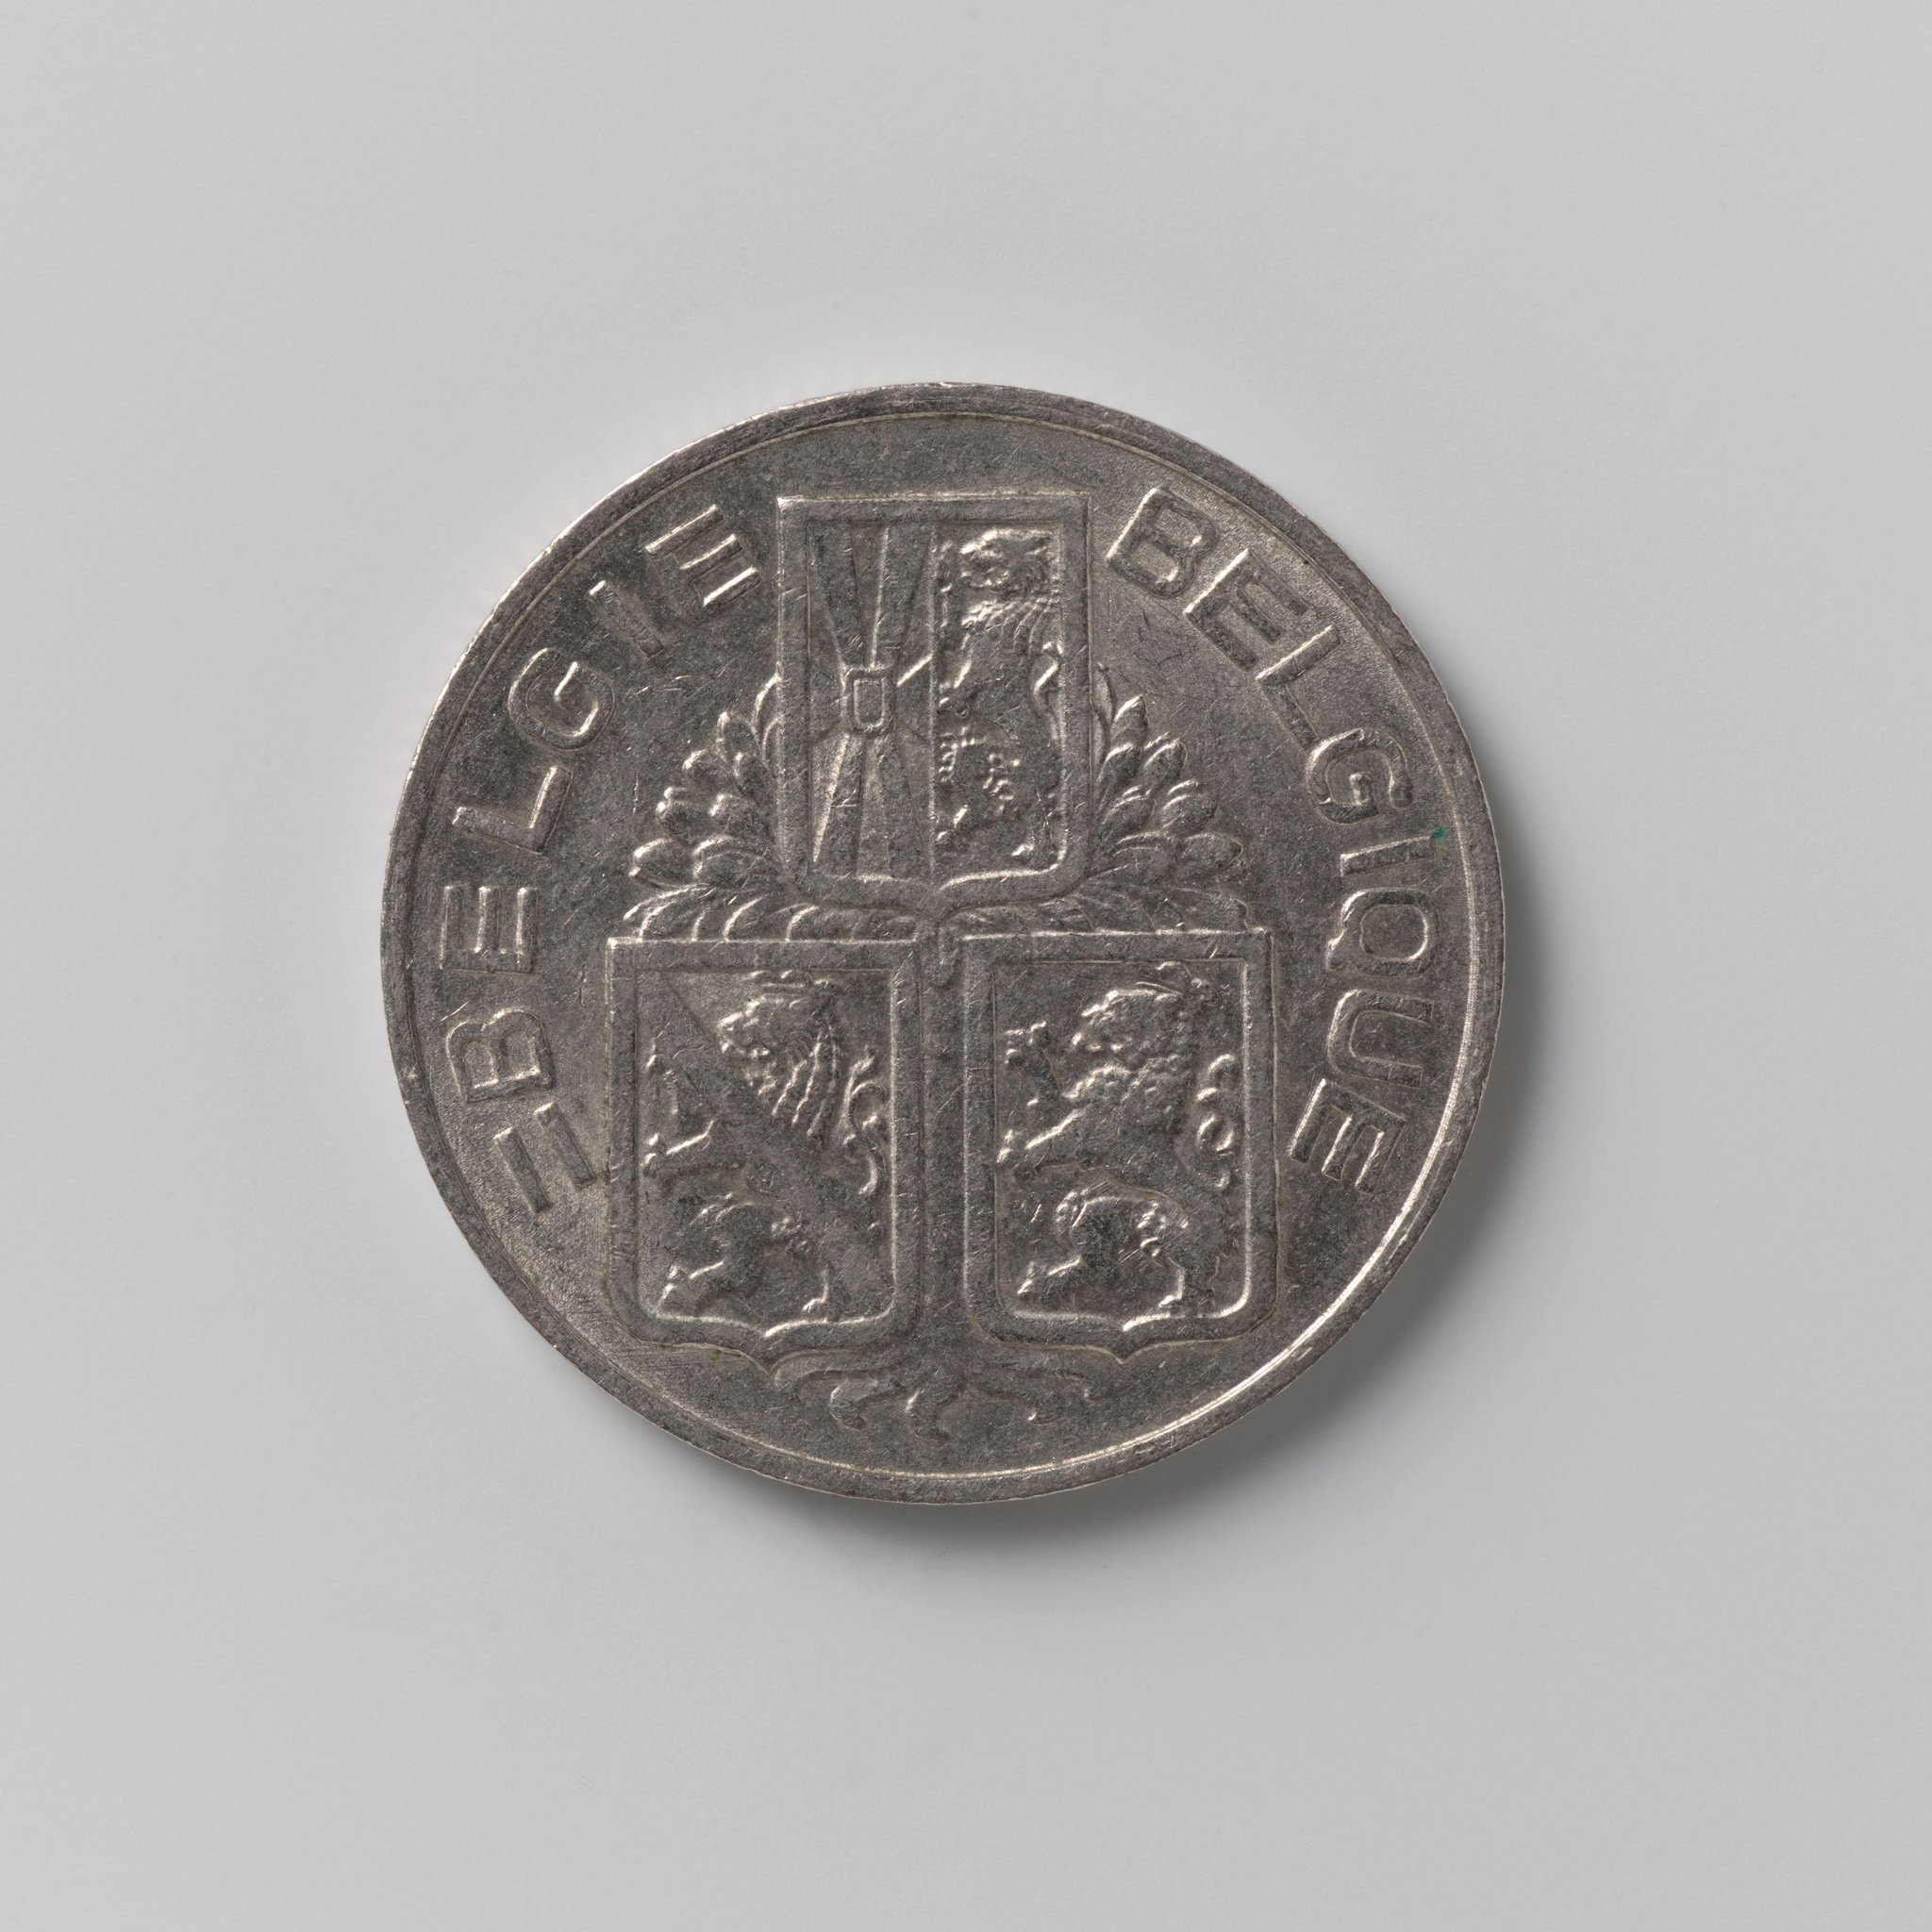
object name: coin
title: Frank uit België van Leopold III, 1940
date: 1940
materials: nickel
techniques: striking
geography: brussels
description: Nikkelen munt. Voorzijde: zittende leeuw naar rechts, naar links omkijkend. Jaaartal in afsnede. Keerzijde: drie wapenschilden op boom. Kartelrand.